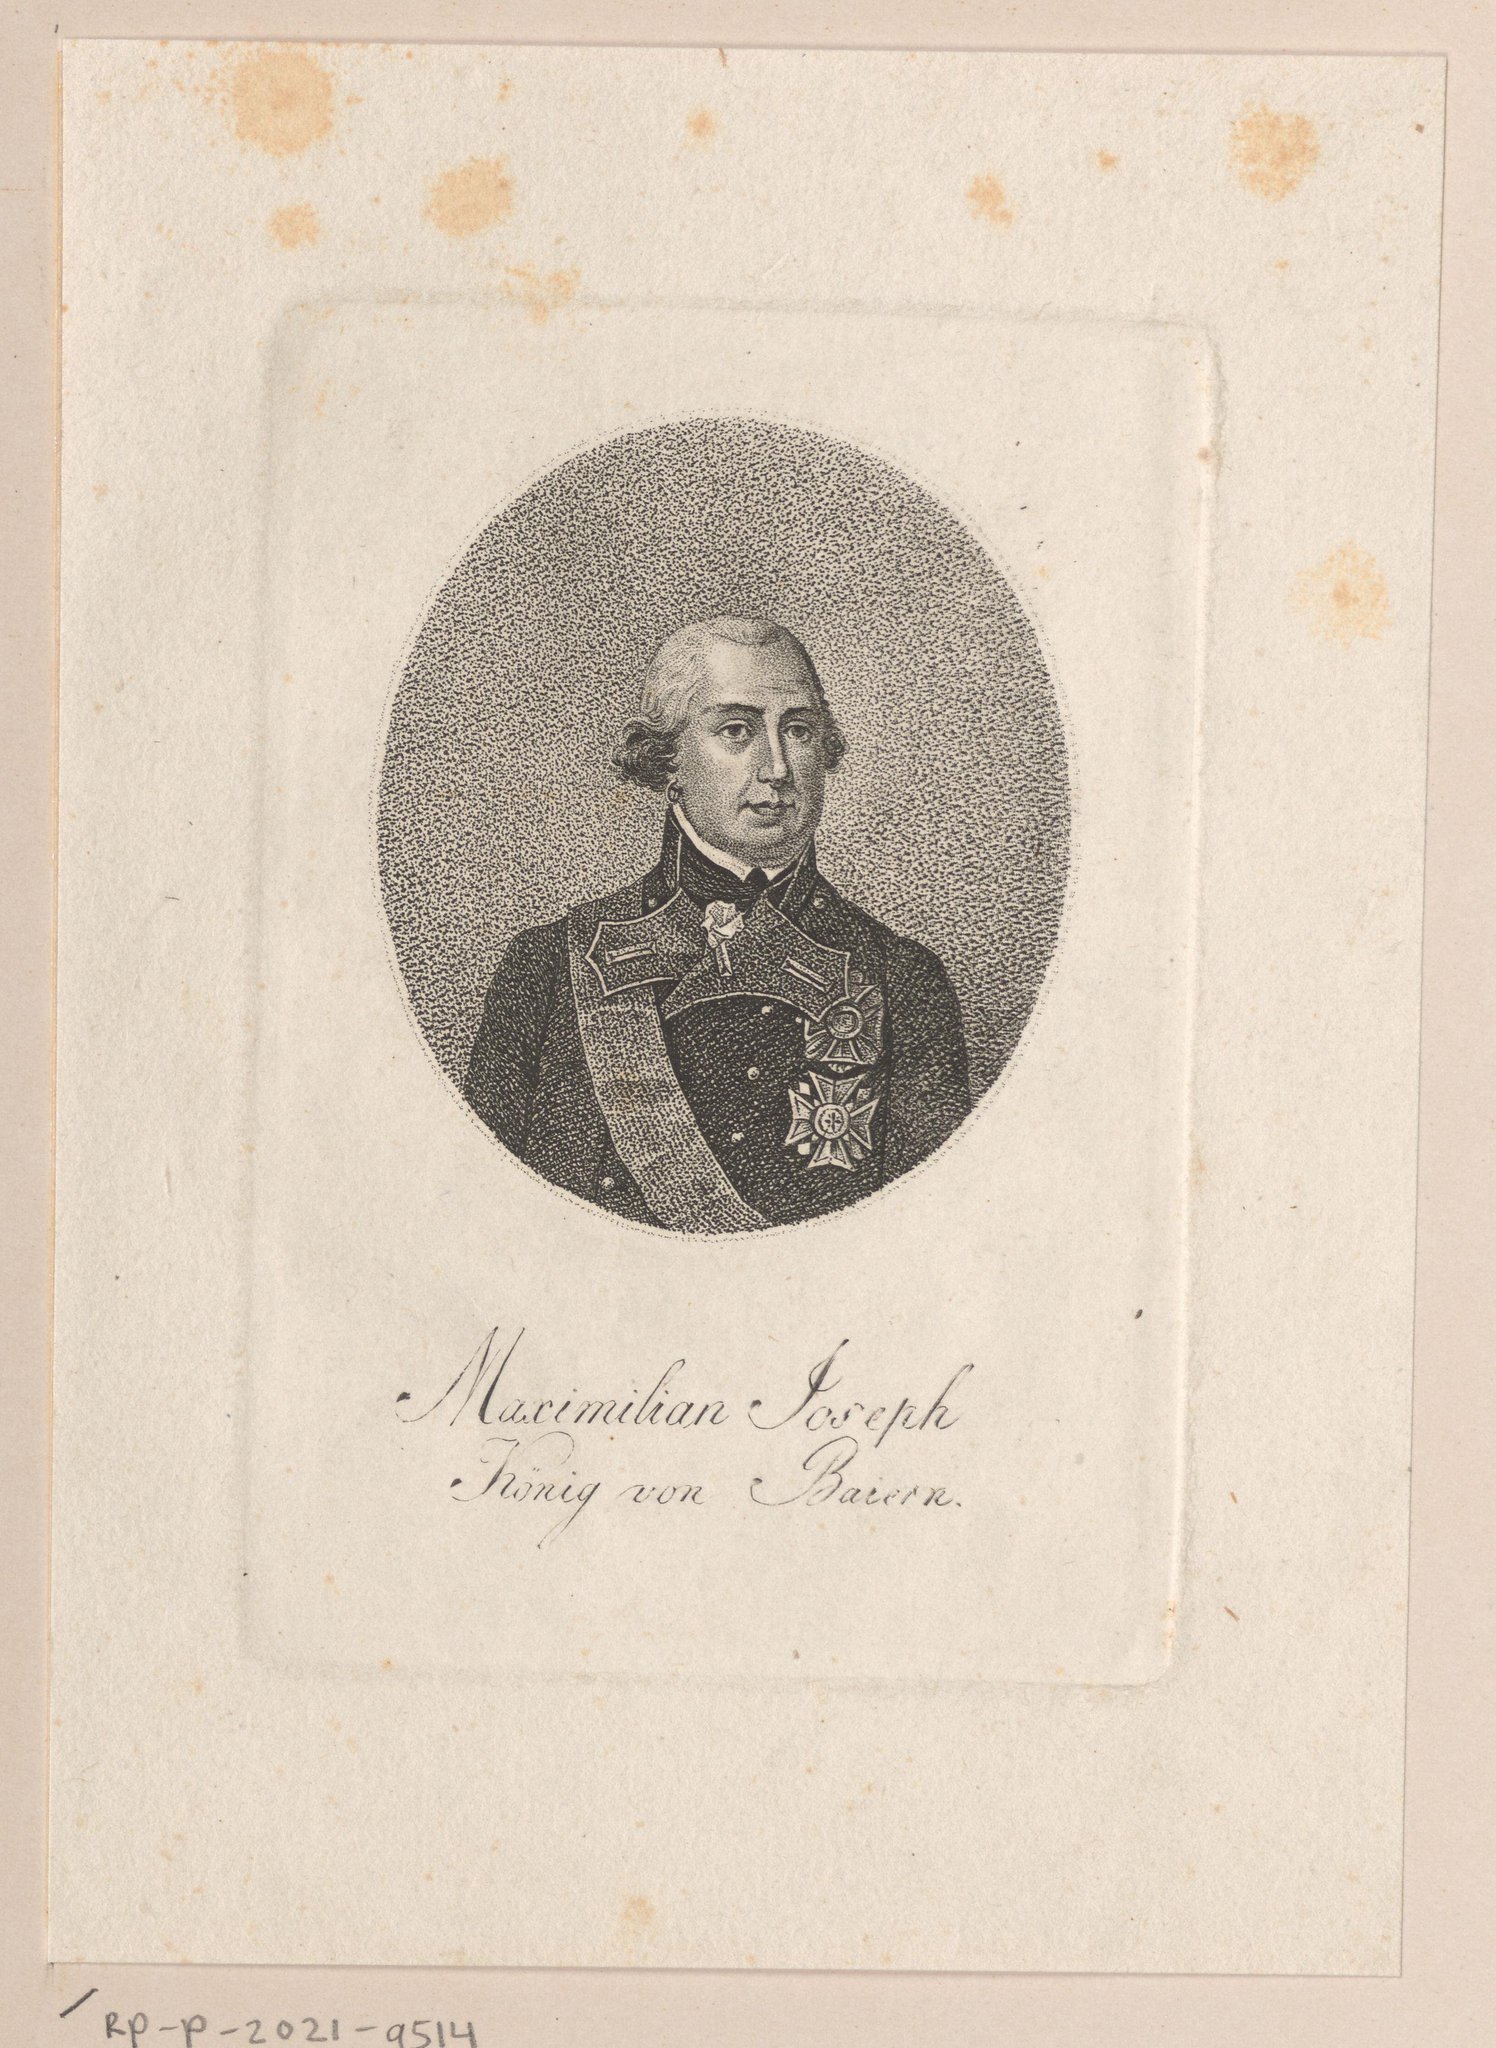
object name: print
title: Portret van Maximiliaan I Jozef van Beieren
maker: Anonymous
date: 1806-1825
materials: paper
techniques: etching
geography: germany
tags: maximiliaan i jozef (koning van beieren), historical persons, king